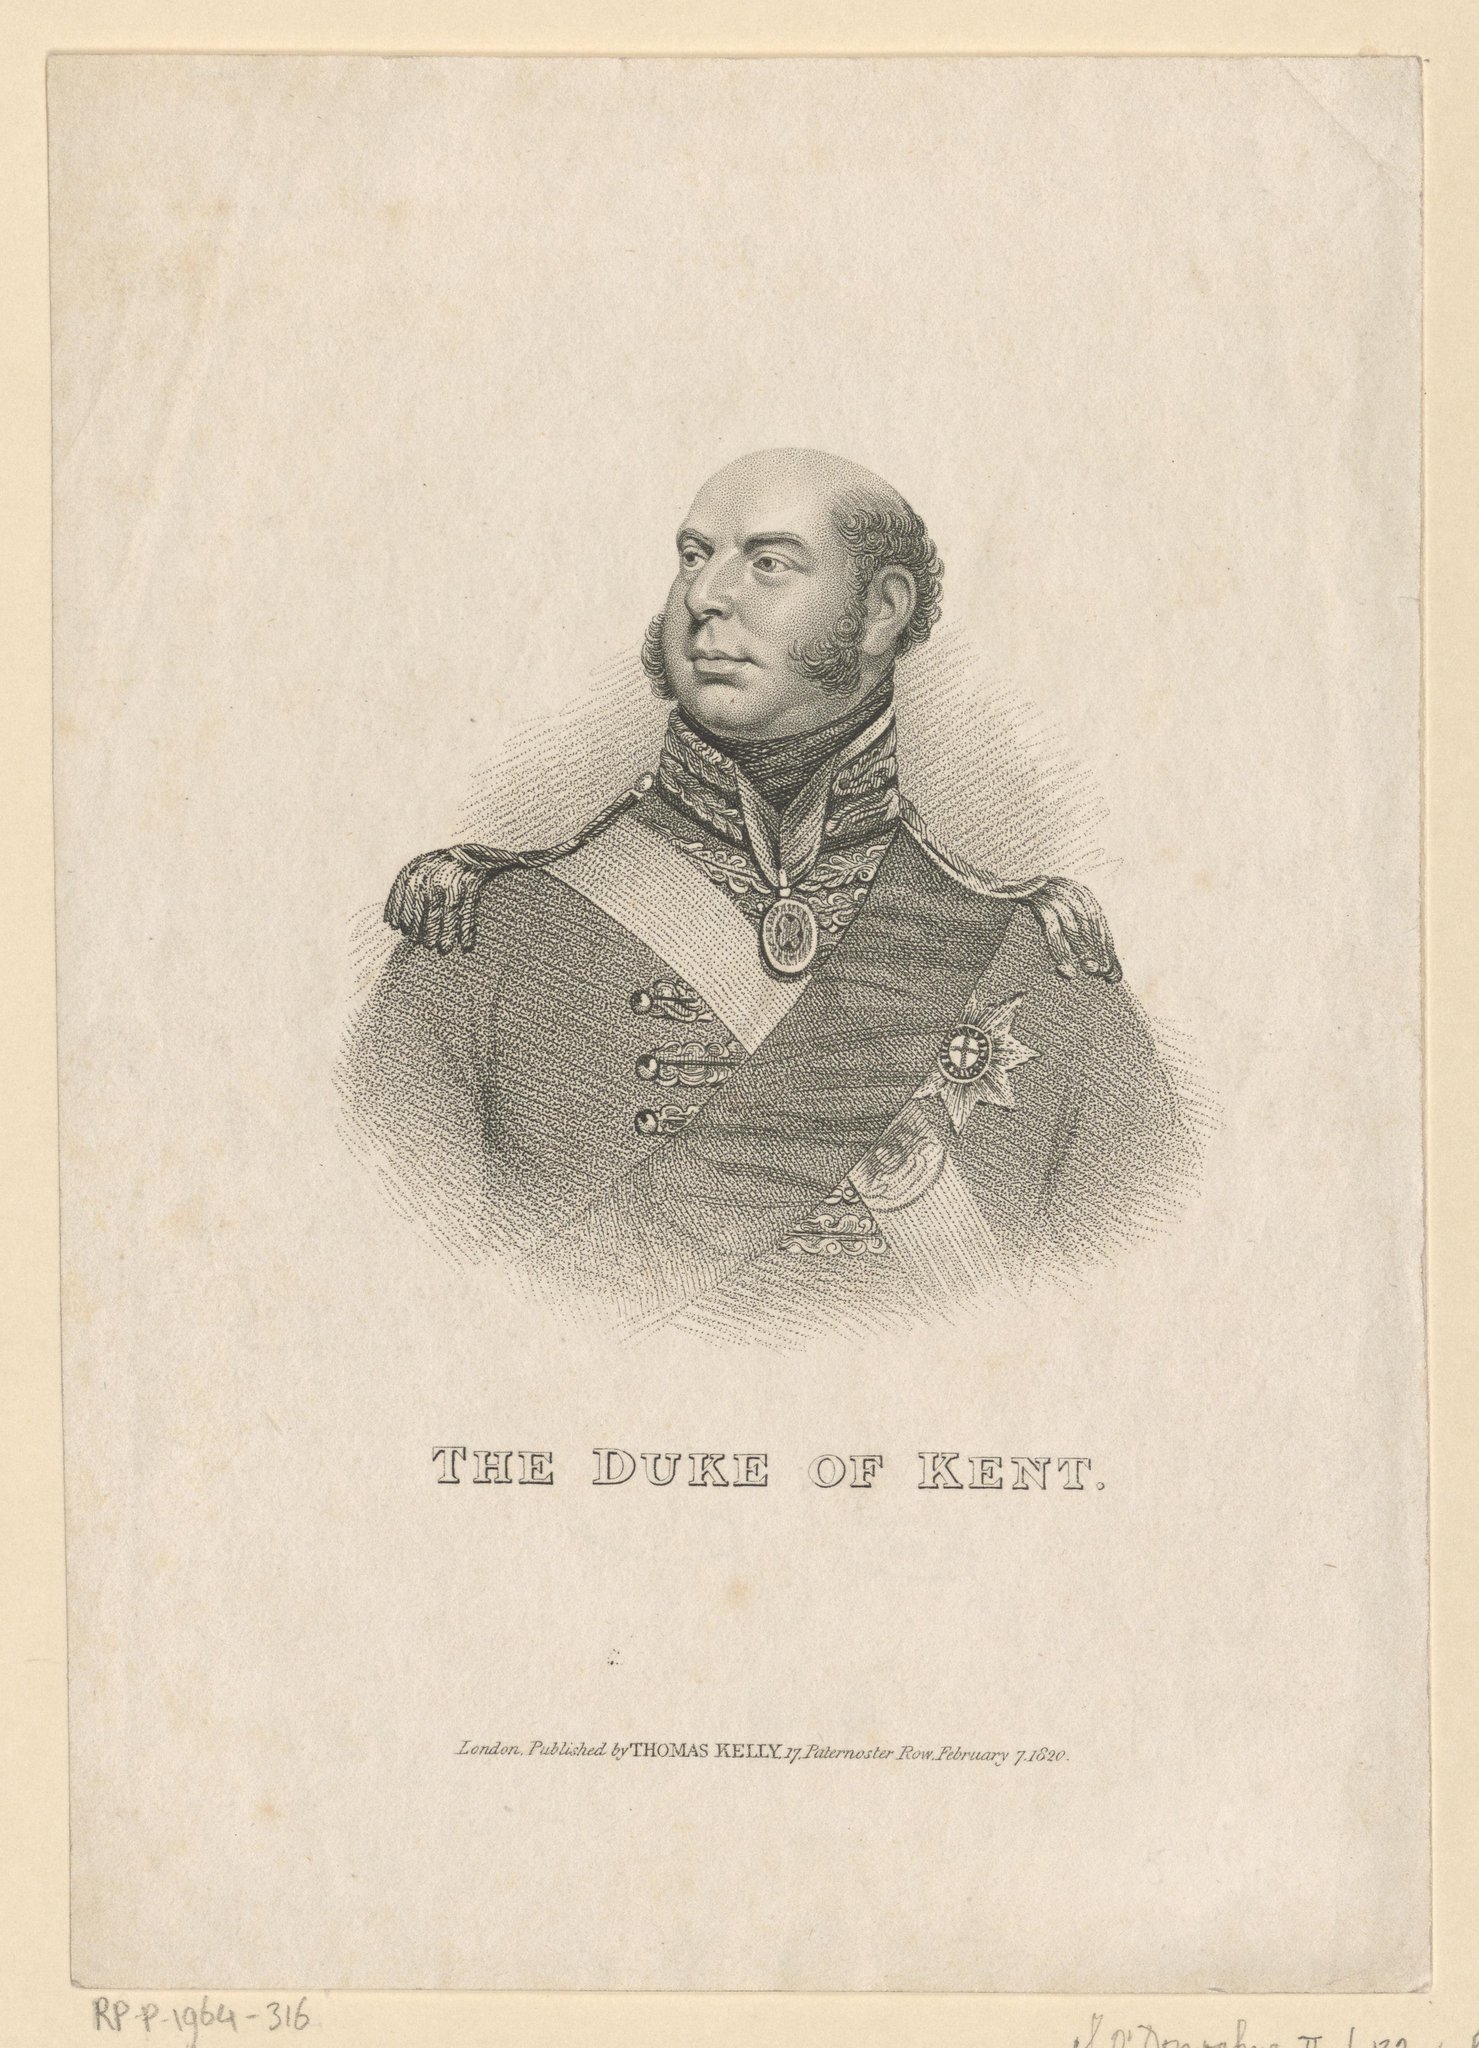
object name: print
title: Portret van Edward Augustus, hertog van Kent en Strathearn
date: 1820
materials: paper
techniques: engraving, etching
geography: london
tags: london, politician, prince, historical persons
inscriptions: collector's mark: Lugt 2228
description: Prent mogelijk uit: The public and private life of his late excellent and most gracious majesty, George the Third (...). Londen: Thomas Kelly, 1821.